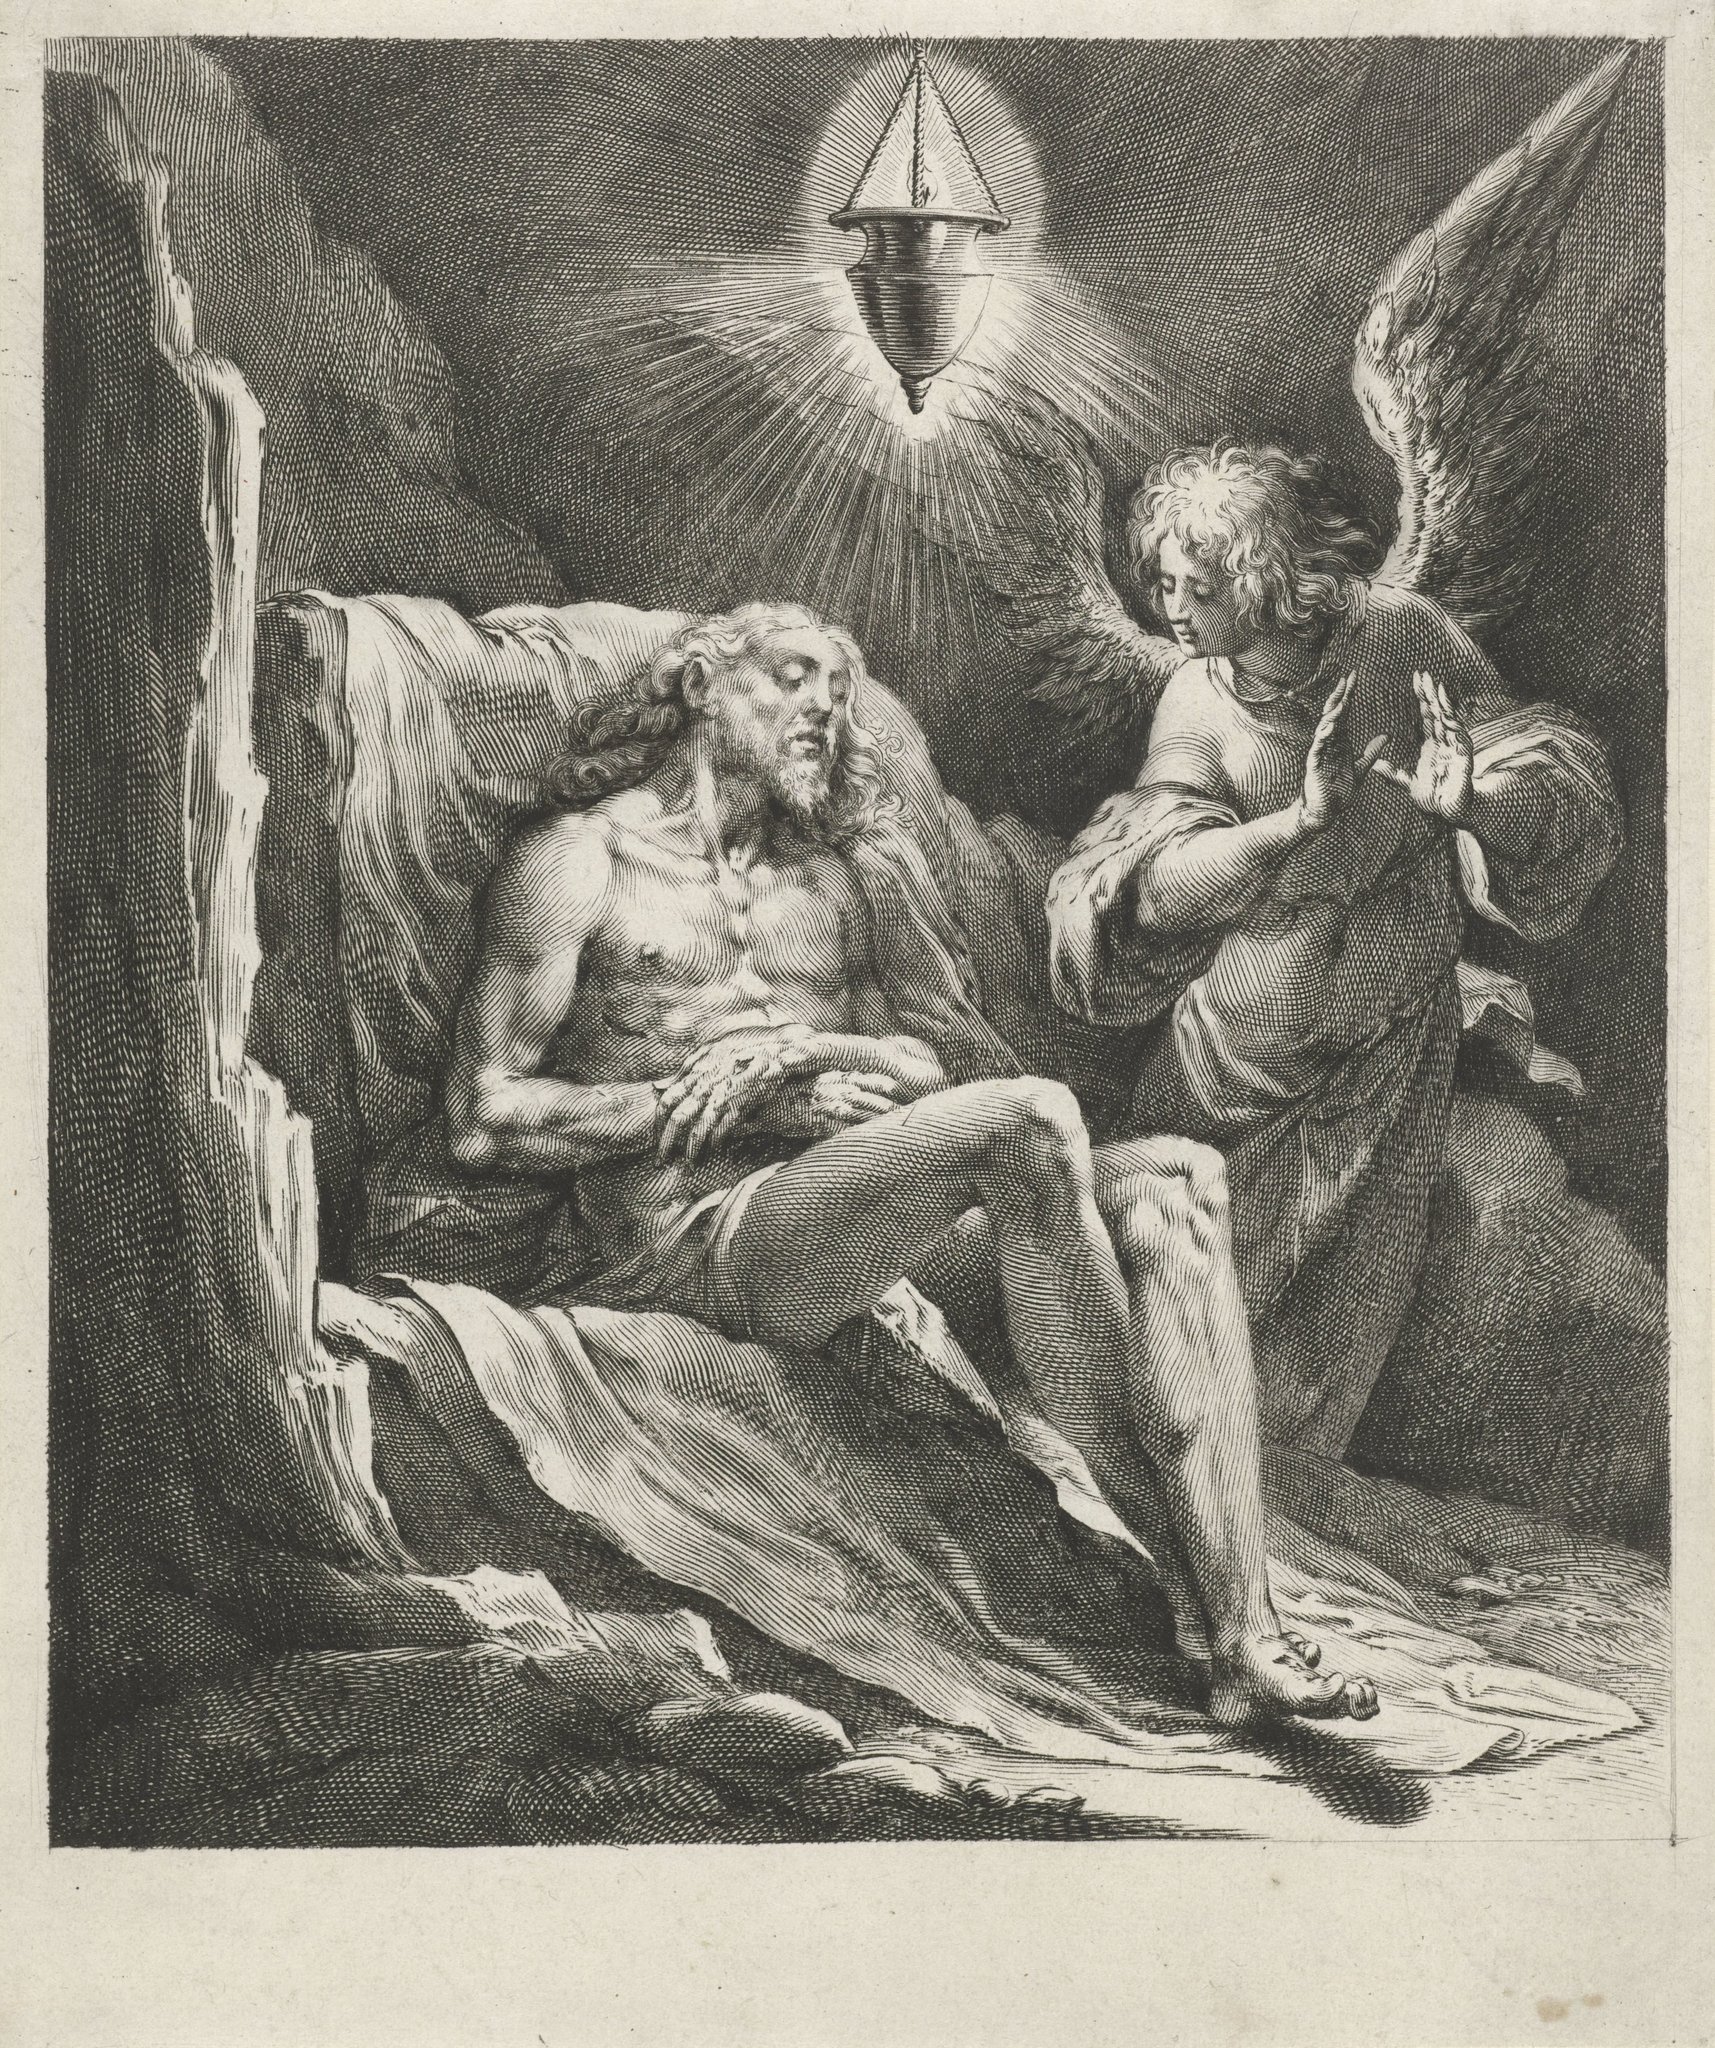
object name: print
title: Dode Christus beweend door een engel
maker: jan harmensz. muller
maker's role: draughtsman, print maker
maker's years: 1571-1628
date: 1593-1597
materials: paper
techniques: engraving, hand coloring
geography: amsterdam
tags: christ lamented by angels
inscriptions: collector's mark: Lugt 240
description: Een engel treurt bij de dode Christus. Het tafereel wordt beschenen door een lantaarn.